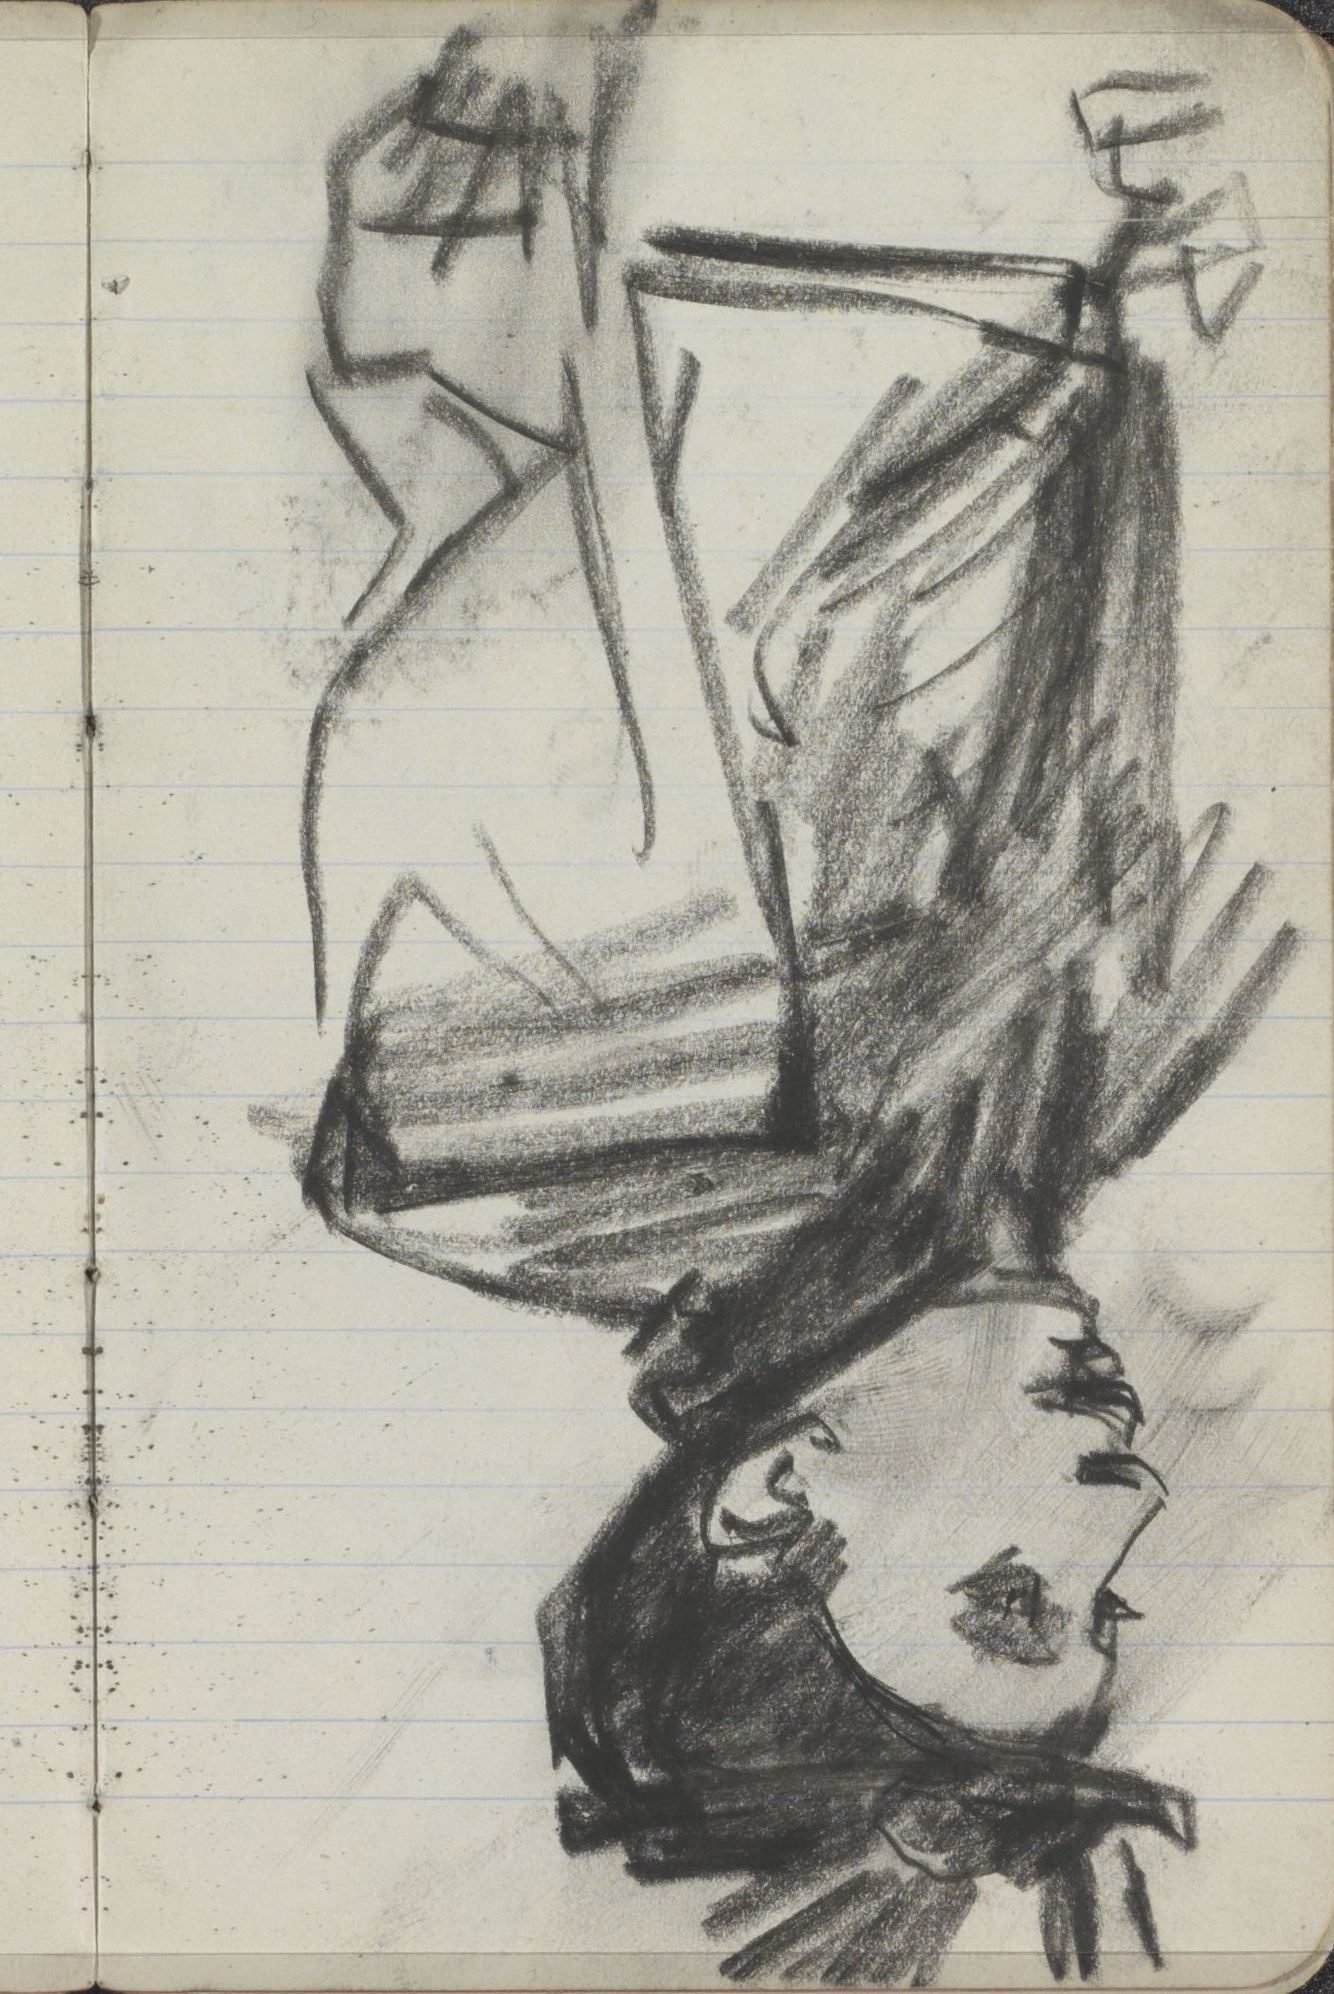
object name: sketchbook leaf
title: Portret van een onbekende vrouw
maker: george hendrik breitner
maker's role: draughtsman, painter, print maker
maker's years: 1857-1923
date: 1893-1898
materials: chalk, paper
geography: amsterdam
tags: adult woman, anonymous historical person portrayed - bb - woman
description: Pagina 58 uit een schetsboek met 38 bladen.